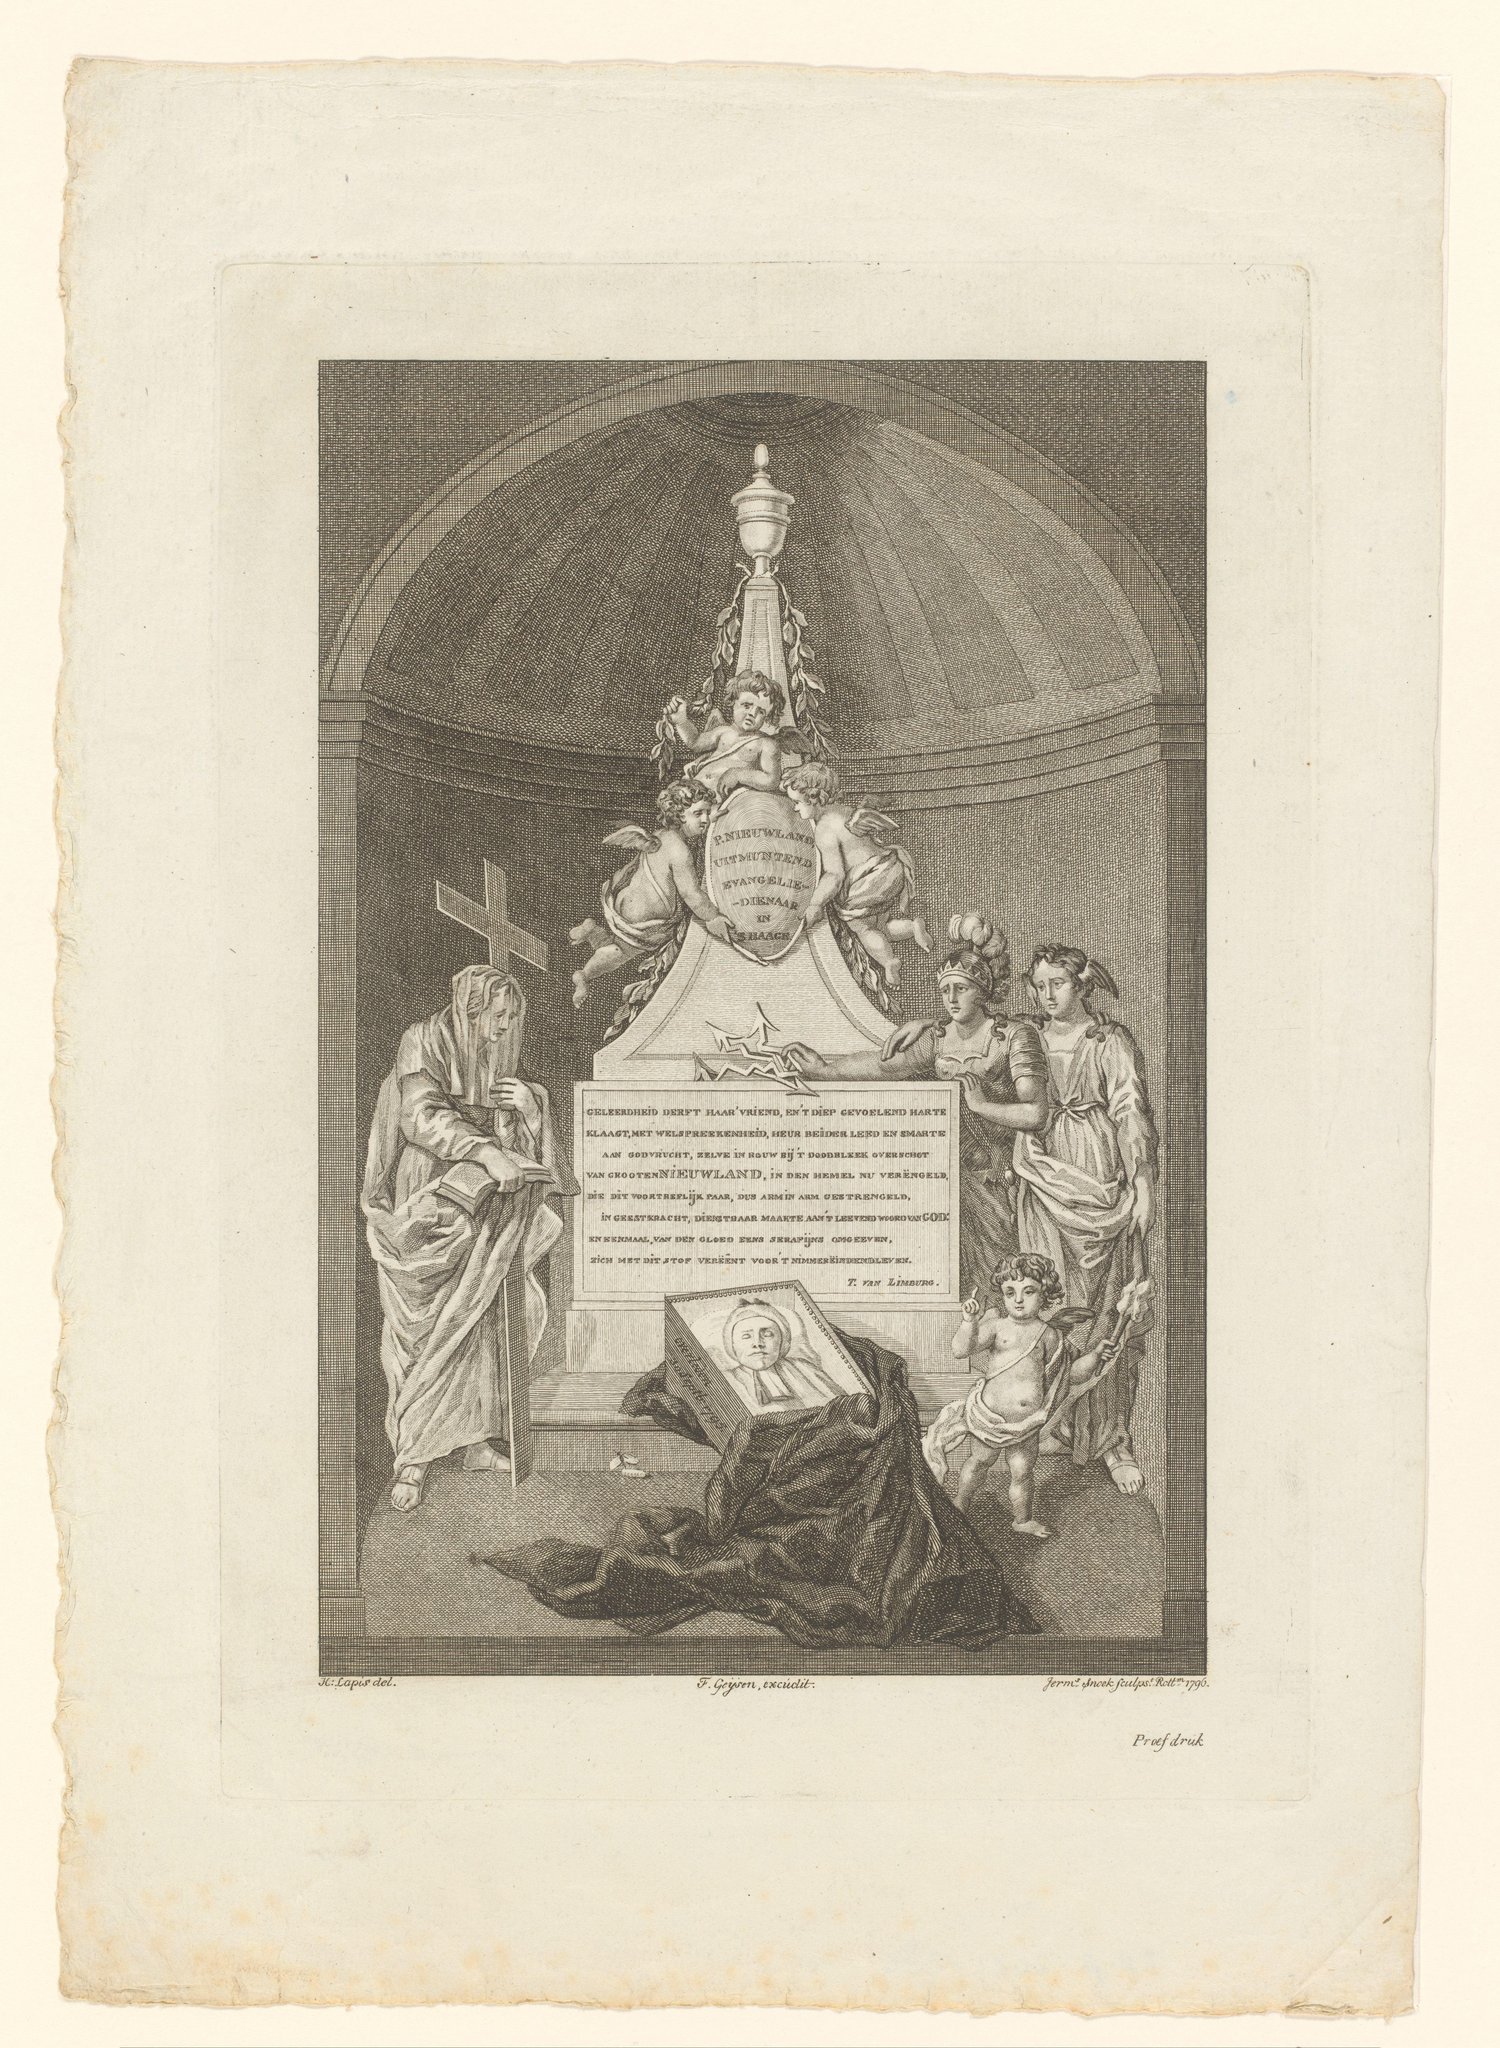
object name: print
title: Grafmonument voor Petrus Nieuwland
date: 1796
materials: paper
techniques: etching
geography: rotterdam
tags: the hague, faith, 'fides'; 'fede', 'fede catholica', 'fede christiana', 'fede christiana catholica' (ripa) ~ one of the three theological virtues, historical persons, mourning the dead, grave-building, monumental tomb, cupids: 'amores', 'amoretti', 'putti'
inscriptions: date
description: Rondom het monument verschillende putti. Links staat een huilende personificatie van het Geloof. Voor het monument een open grafkist met het lichaam van Nieuwland.